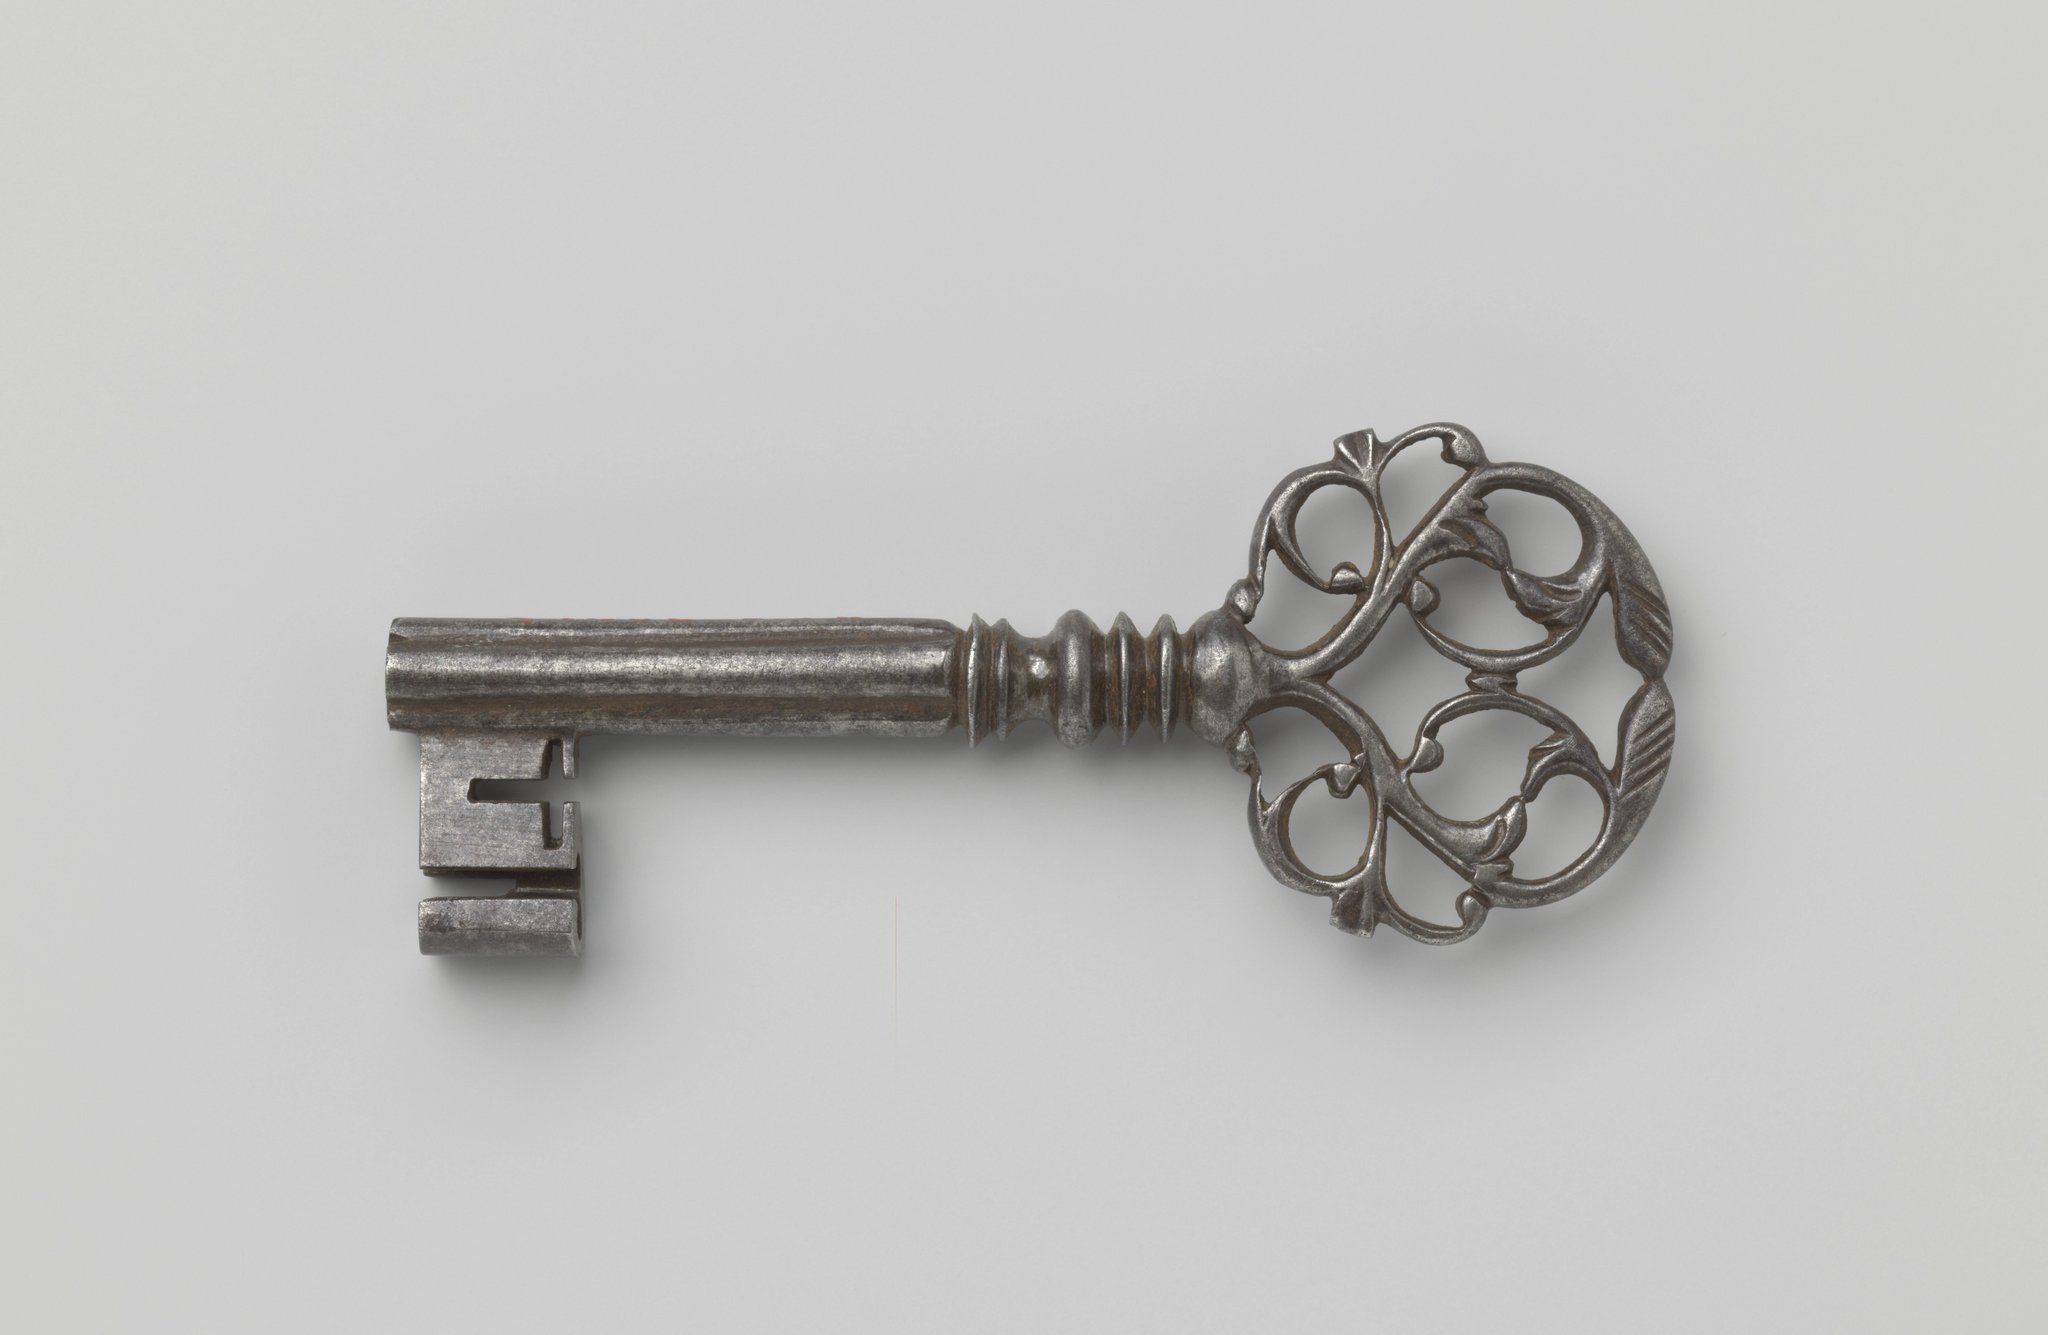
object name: key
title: Sleutel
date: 1600-1699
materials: iron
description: Sleutel waarvan de greep uit blad- en randmotieven is samengesteld. De schacht is vierpasvormig geboord en gaat bij de greep over in geledingen.